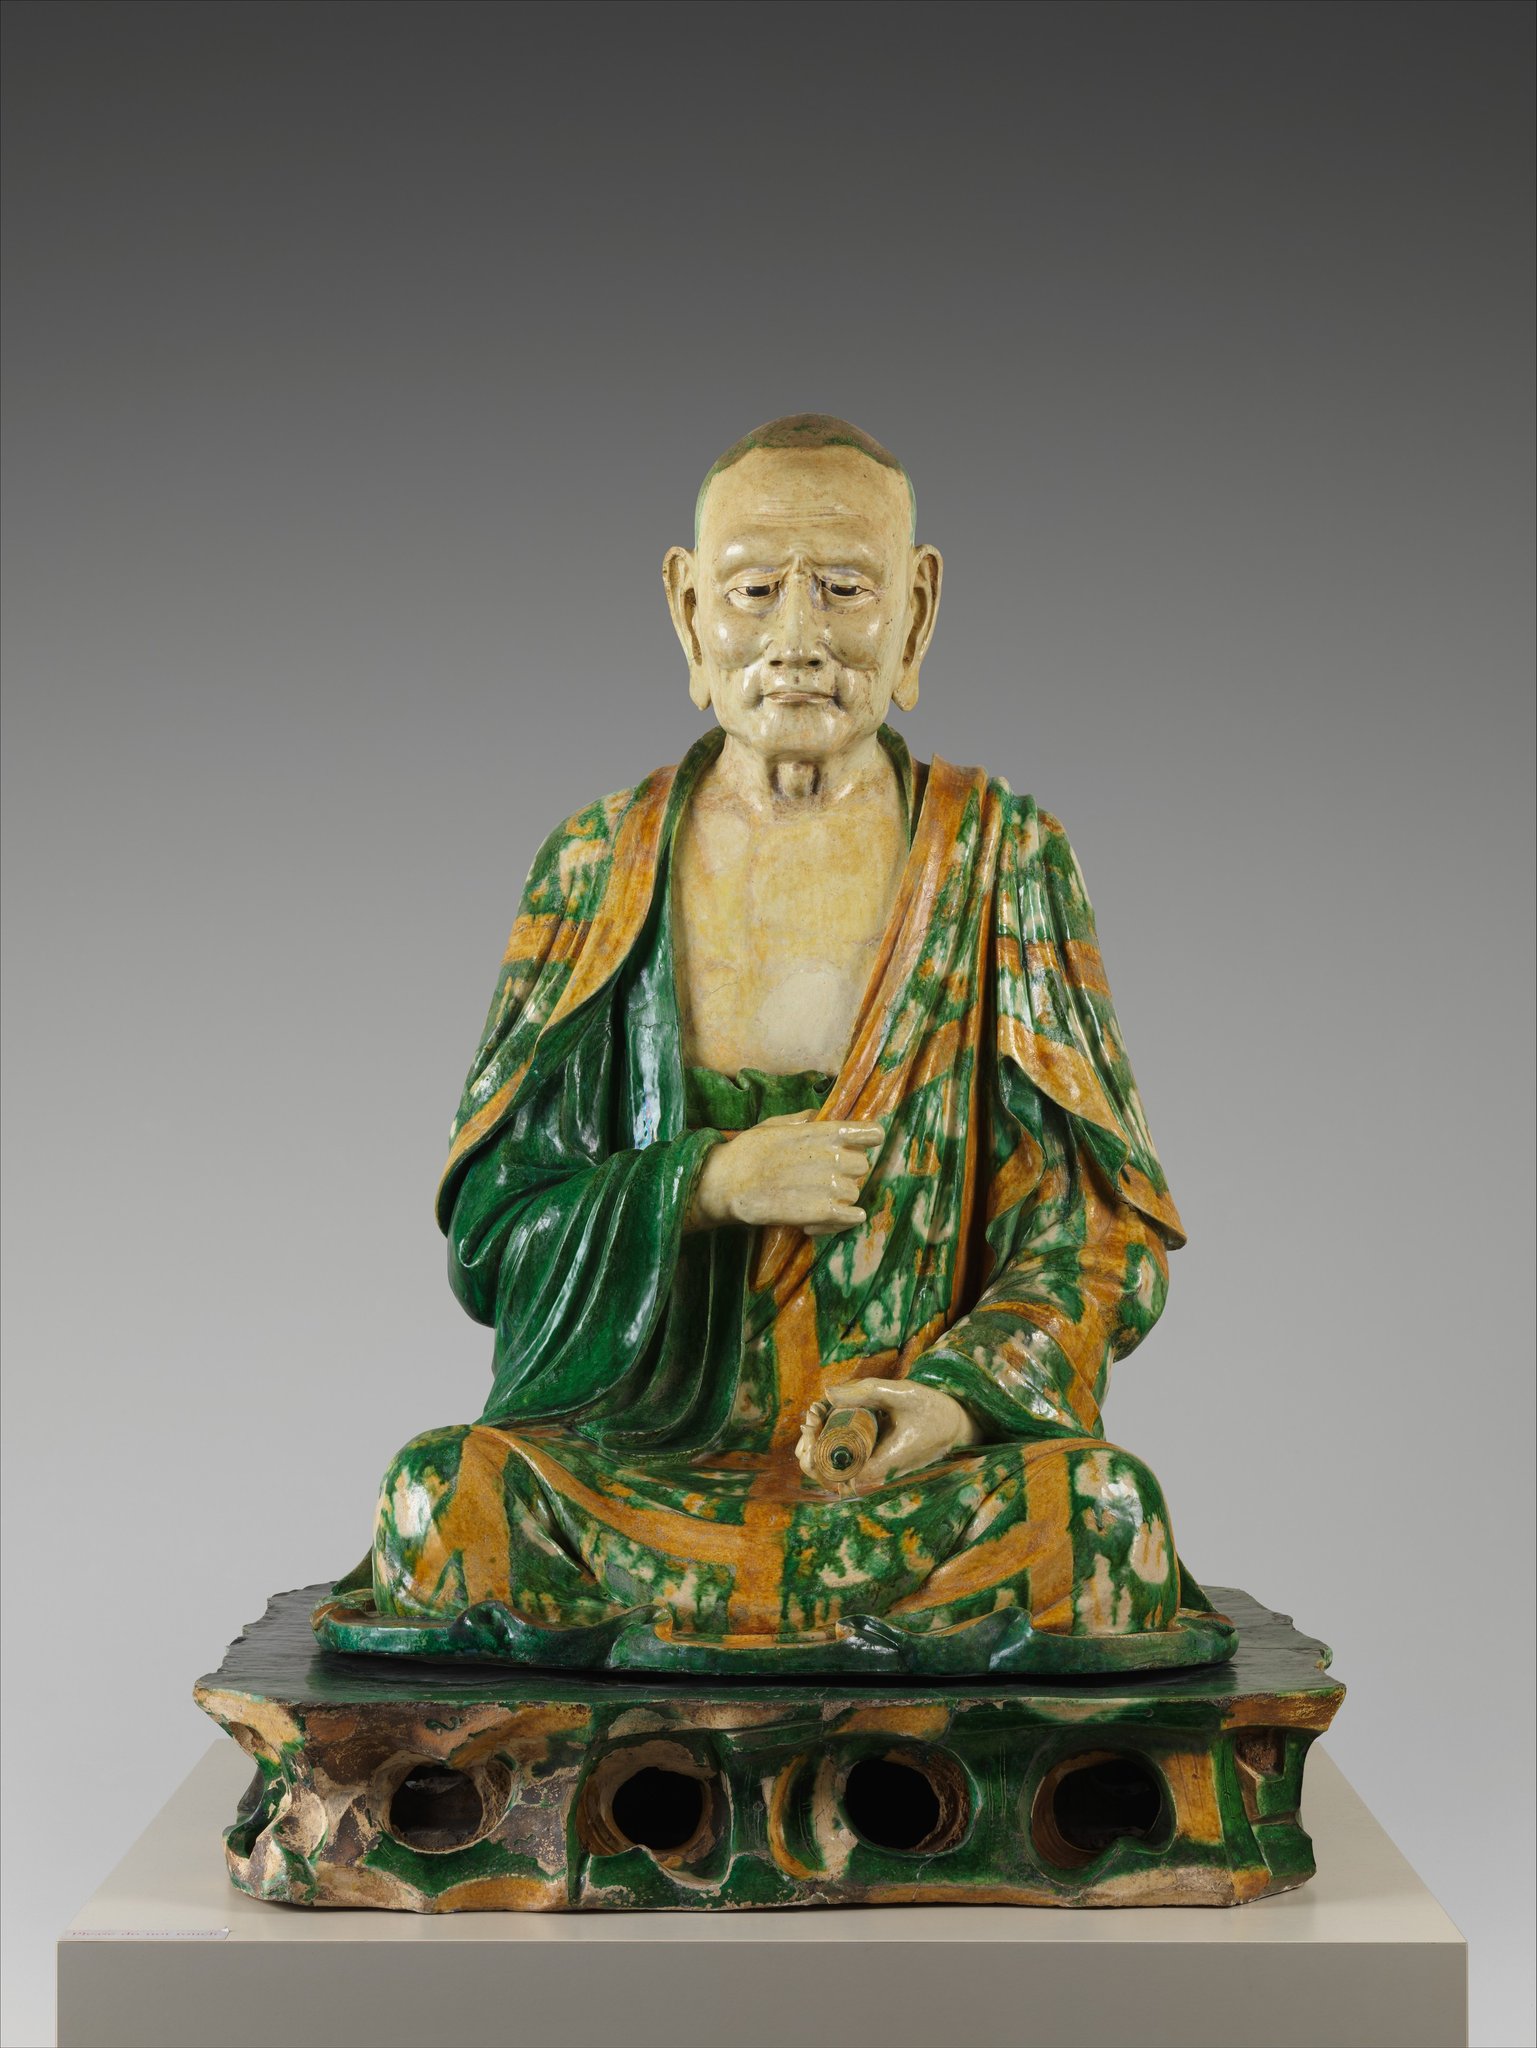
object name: figure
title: Arhat (Luohan)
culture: chinese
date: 1000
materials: glaze, stoneware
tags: men,buddhism